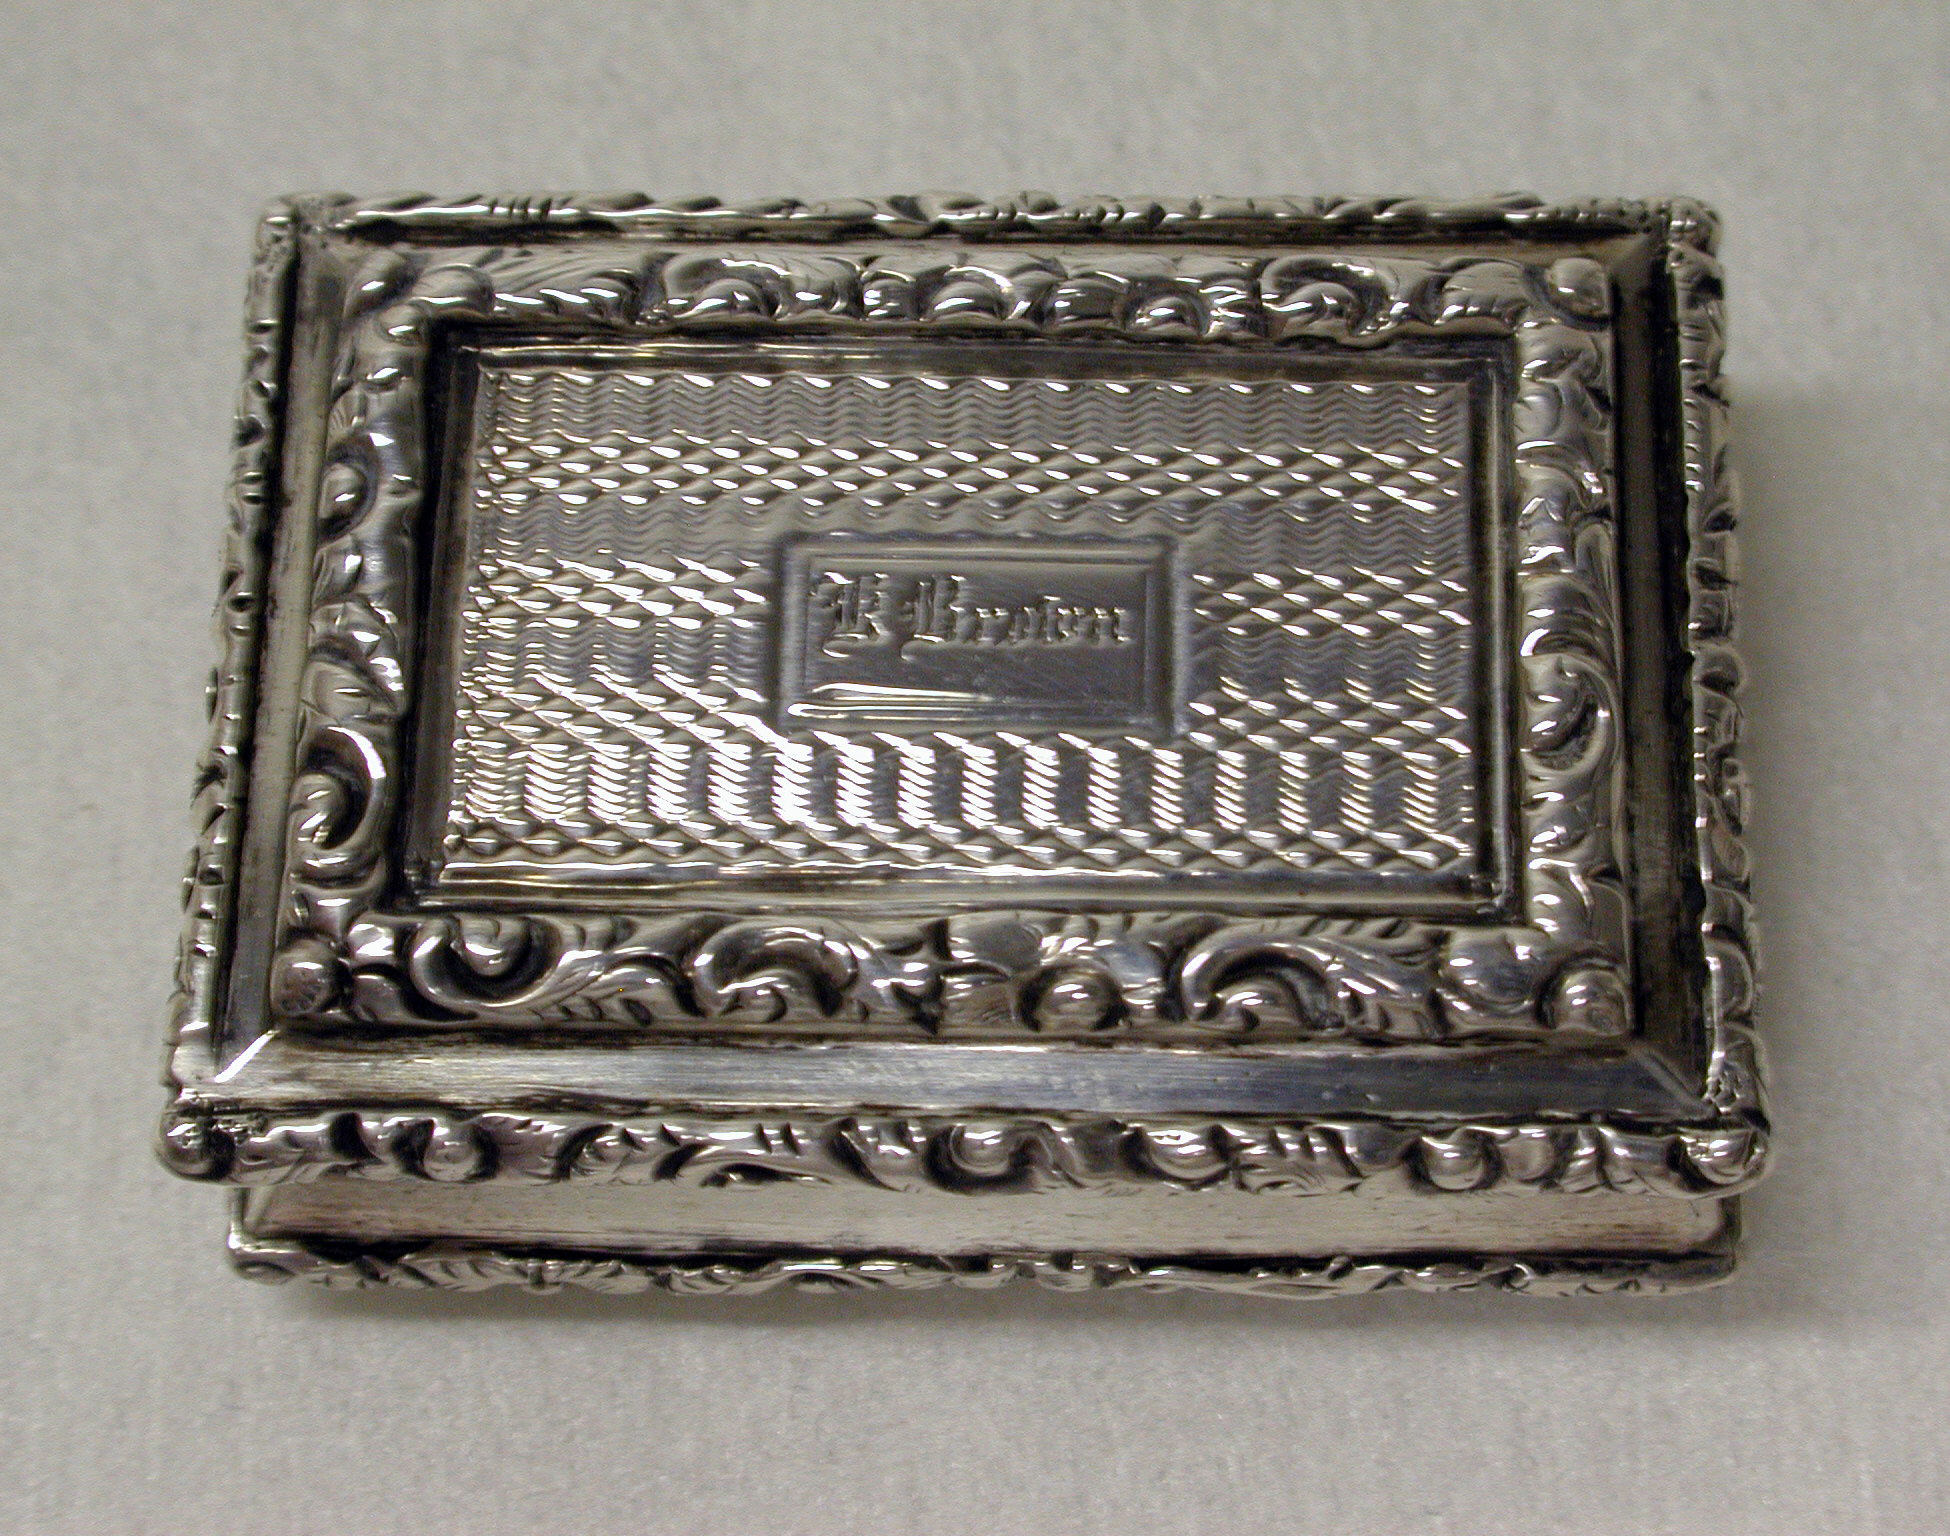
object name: vinaigrette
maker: nathaniel mills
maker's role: maker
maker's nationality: british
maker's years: 1746-1843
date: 1828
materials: silver